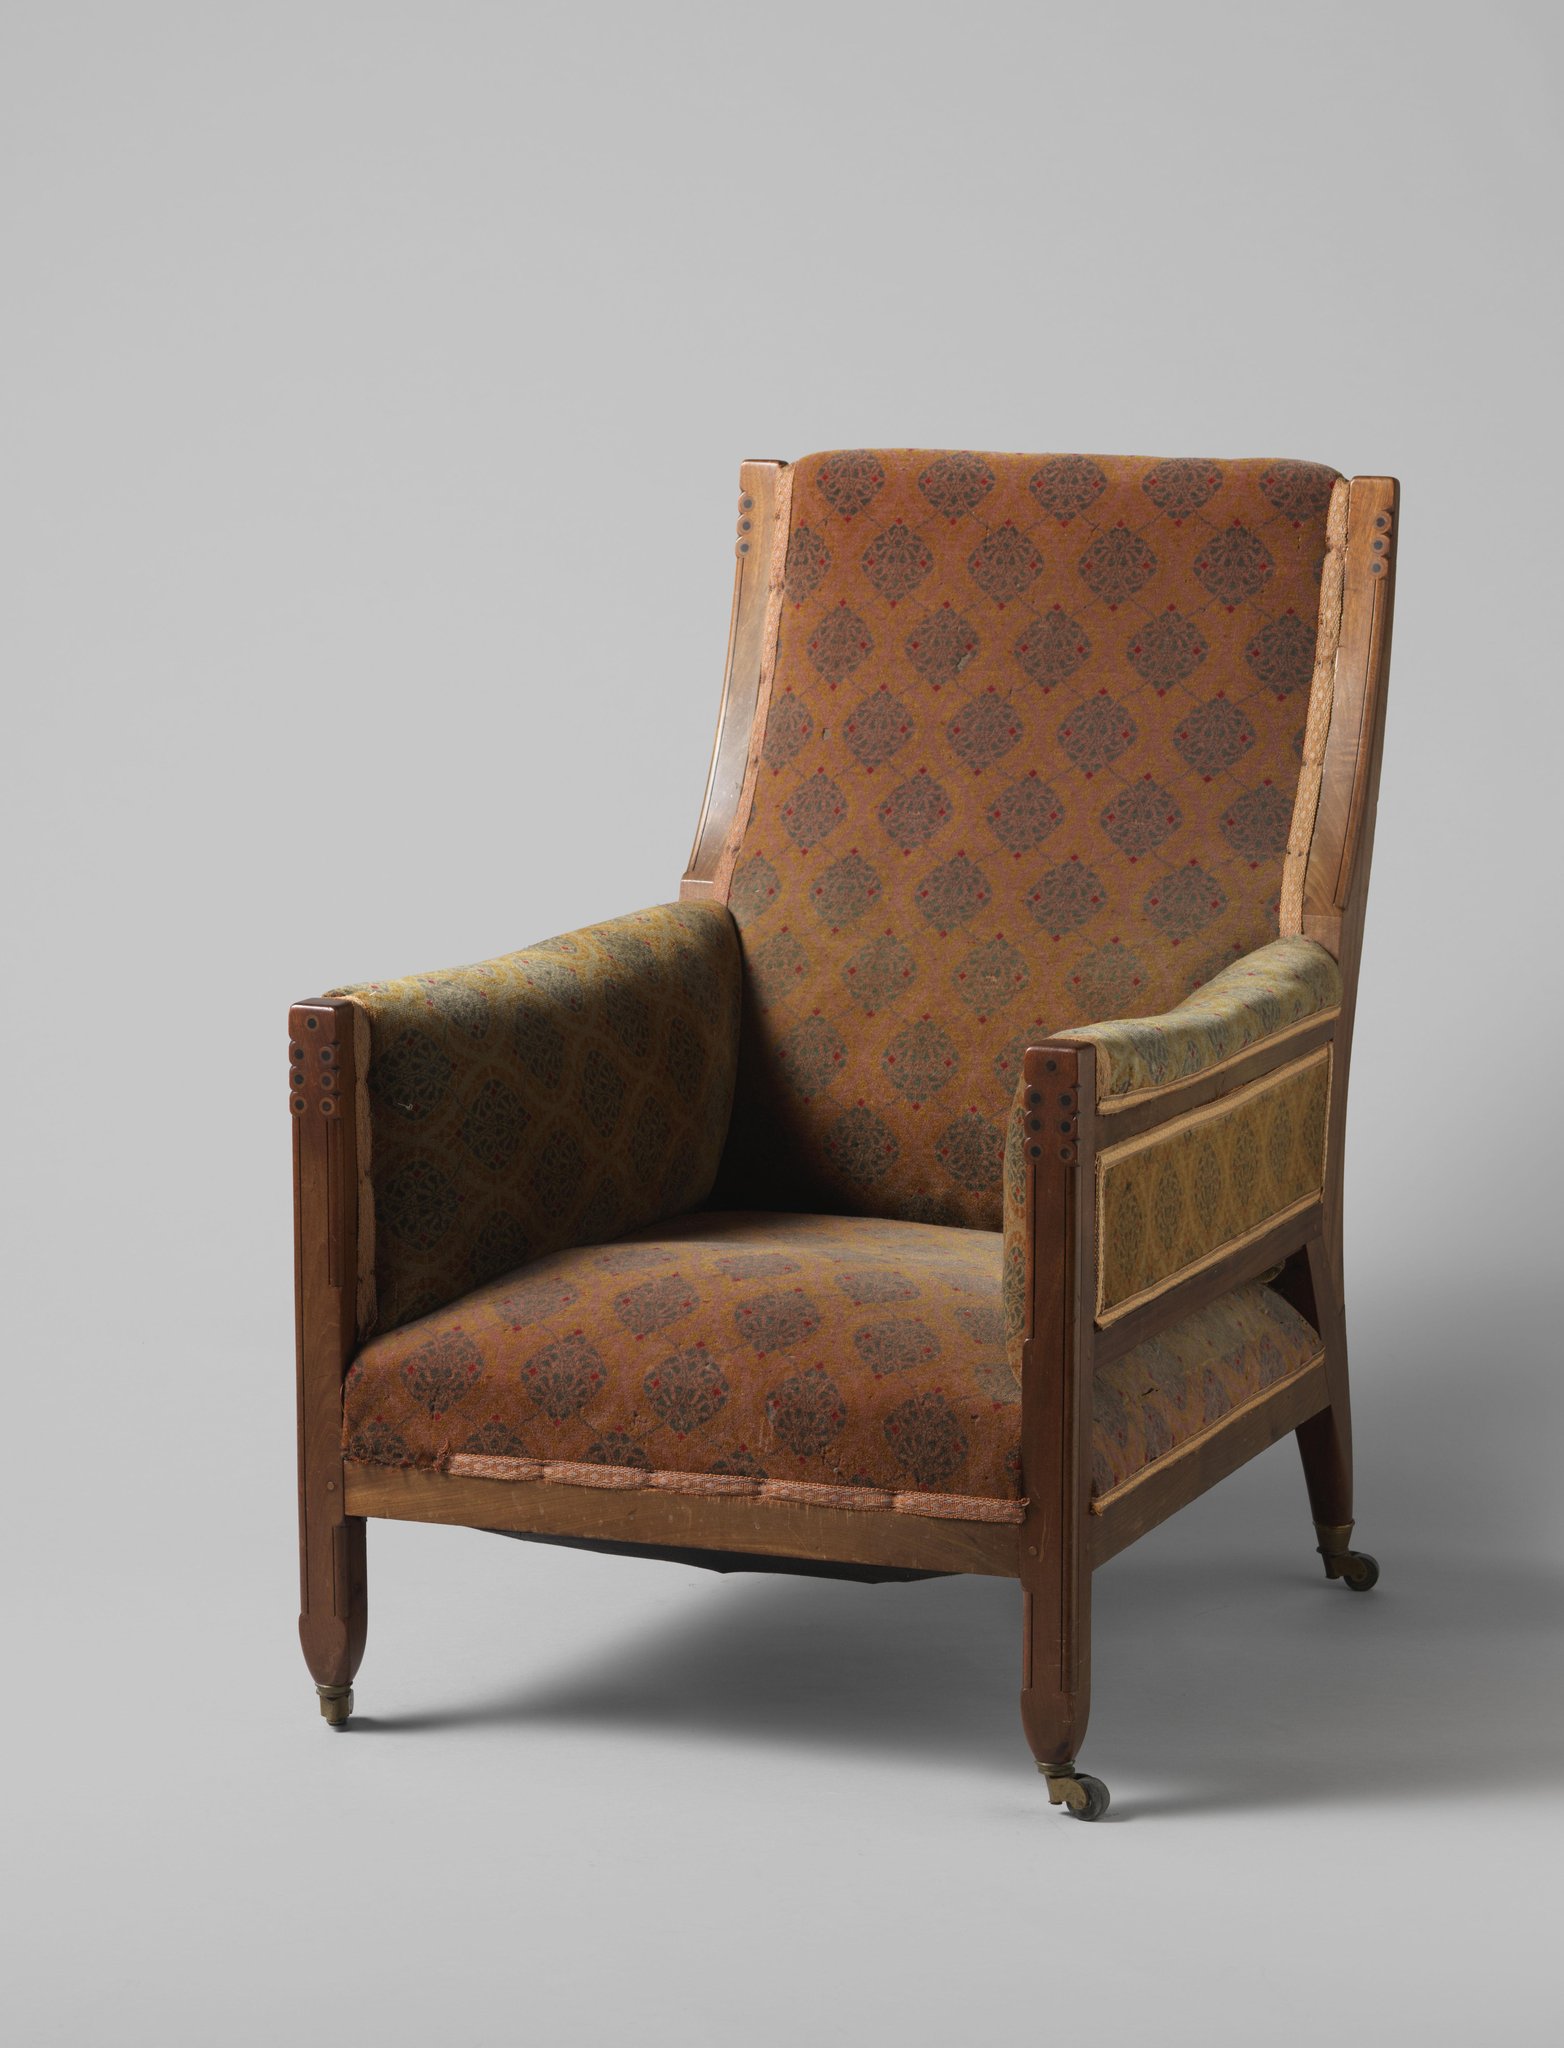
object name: furniture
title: Armstoel ingelegd met cirkels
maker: jacob pieter van den bosch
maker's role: draughtsman, print maker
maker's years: 1868-1948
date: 1920-1925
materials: velvet, wool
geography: netherlands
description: Armstoel van mahoniehout rustend op vier poten. De verjongende voorpoten op wielen lopen door in de armstutten en zijn aan de bovenzijde ingelegd met cirkels van ebbenhout. De schuingestelde achterpoten ondersteunen de armleggers en de geholde rugstijlen die aan de bovenzijde zijn ingelegd met cirkels van ebbenhout. De zitting, de rugleuning en de wangen zijn bekleed met trijp in groen, rood, paars, geel en bruin.